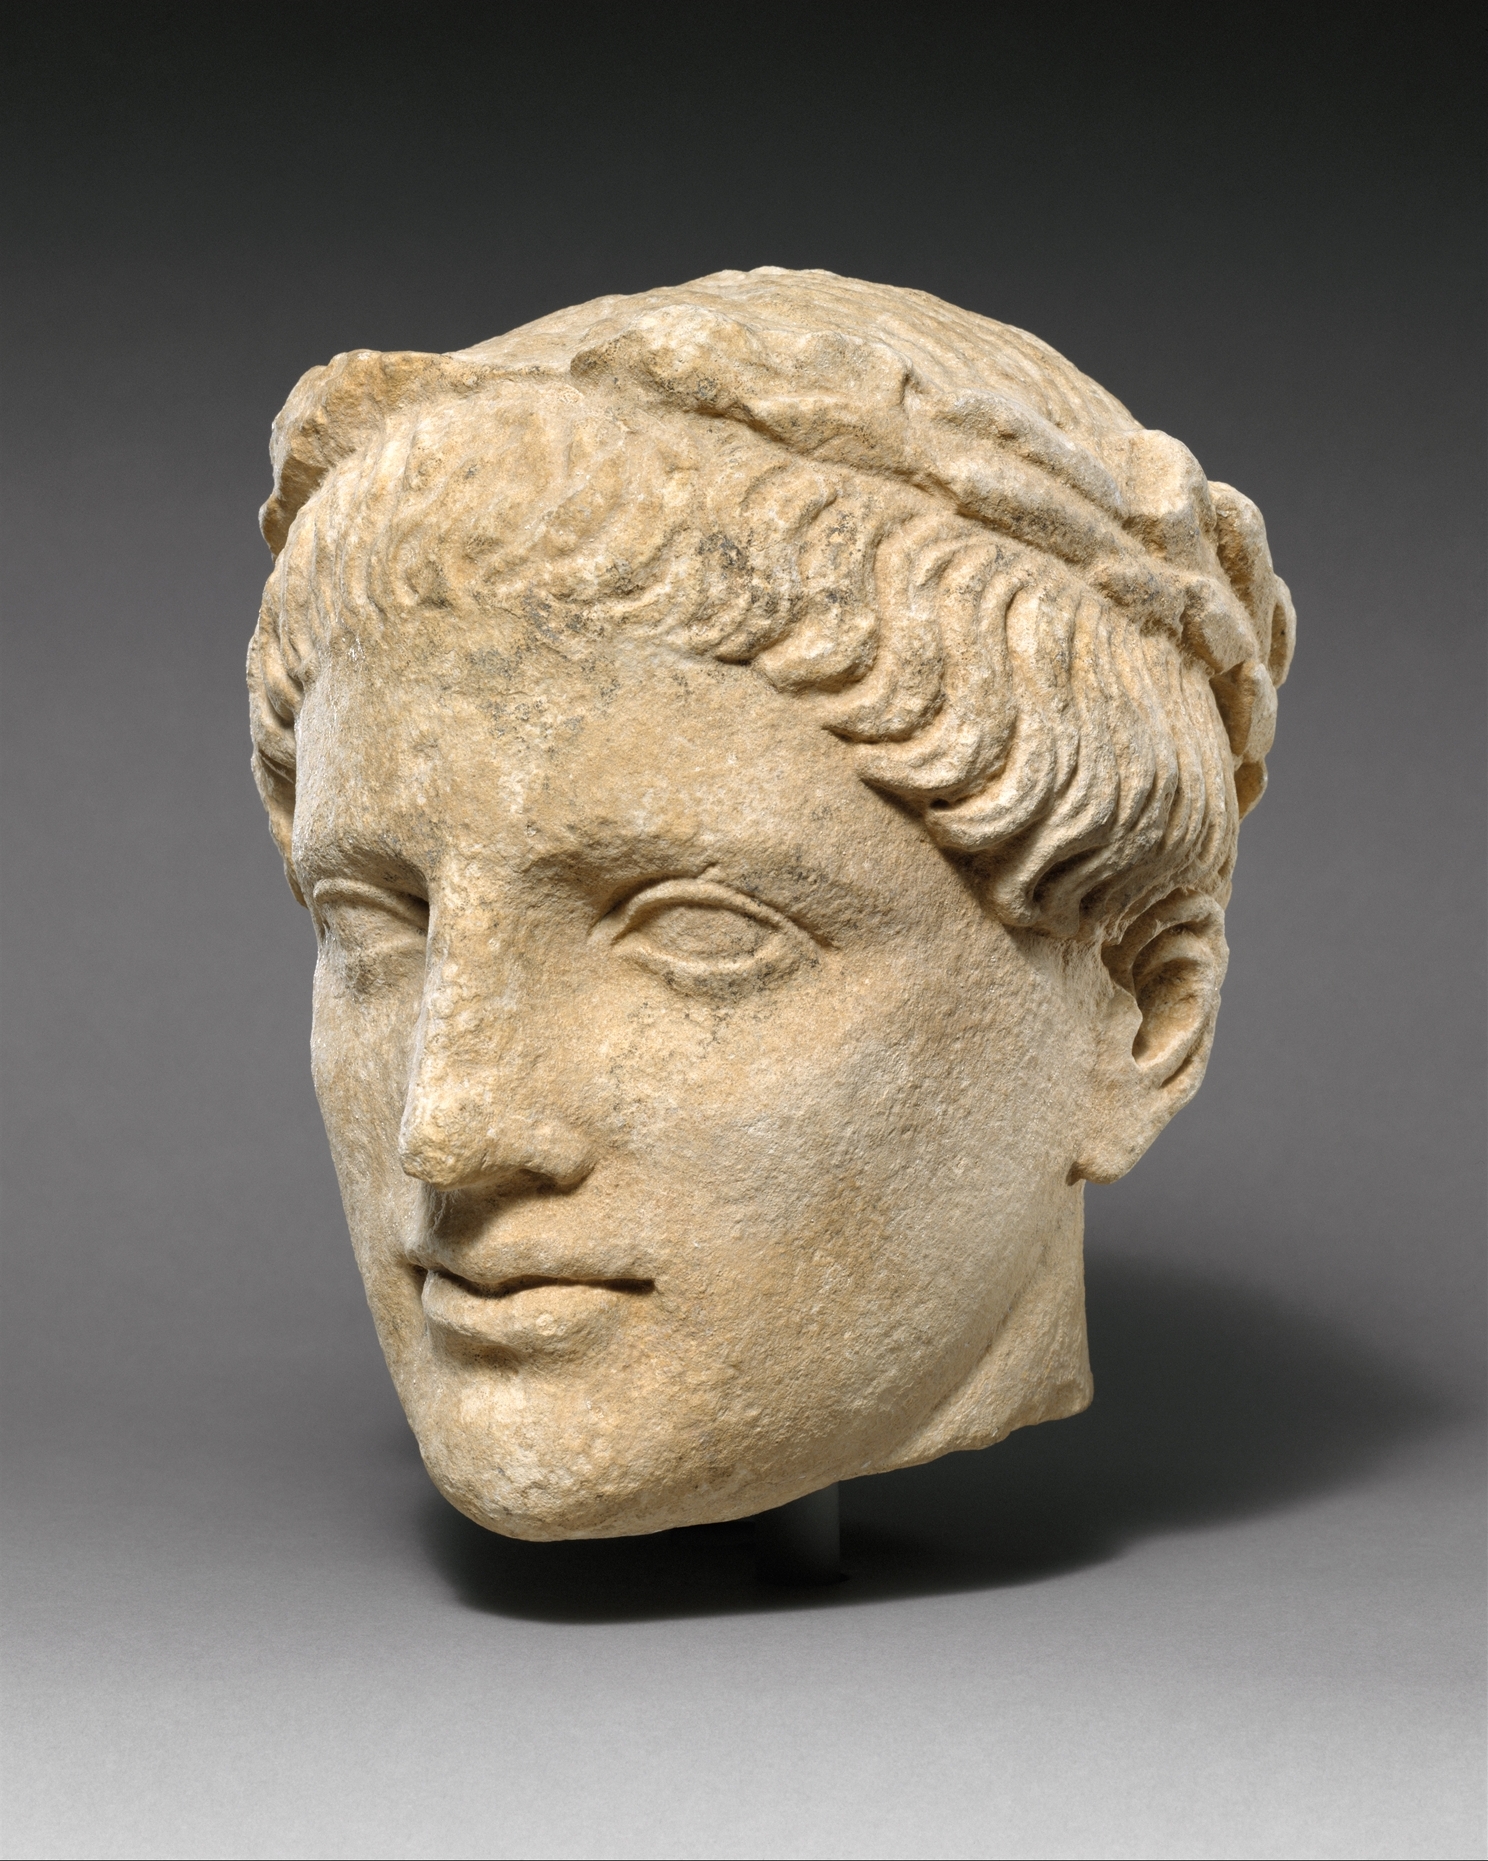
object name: head of a youth with wreath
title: Limestone head of beardless male votary with wreath of leaves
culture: cypriot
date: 267-235 BCE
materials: limestone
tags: heads,men,wreaths